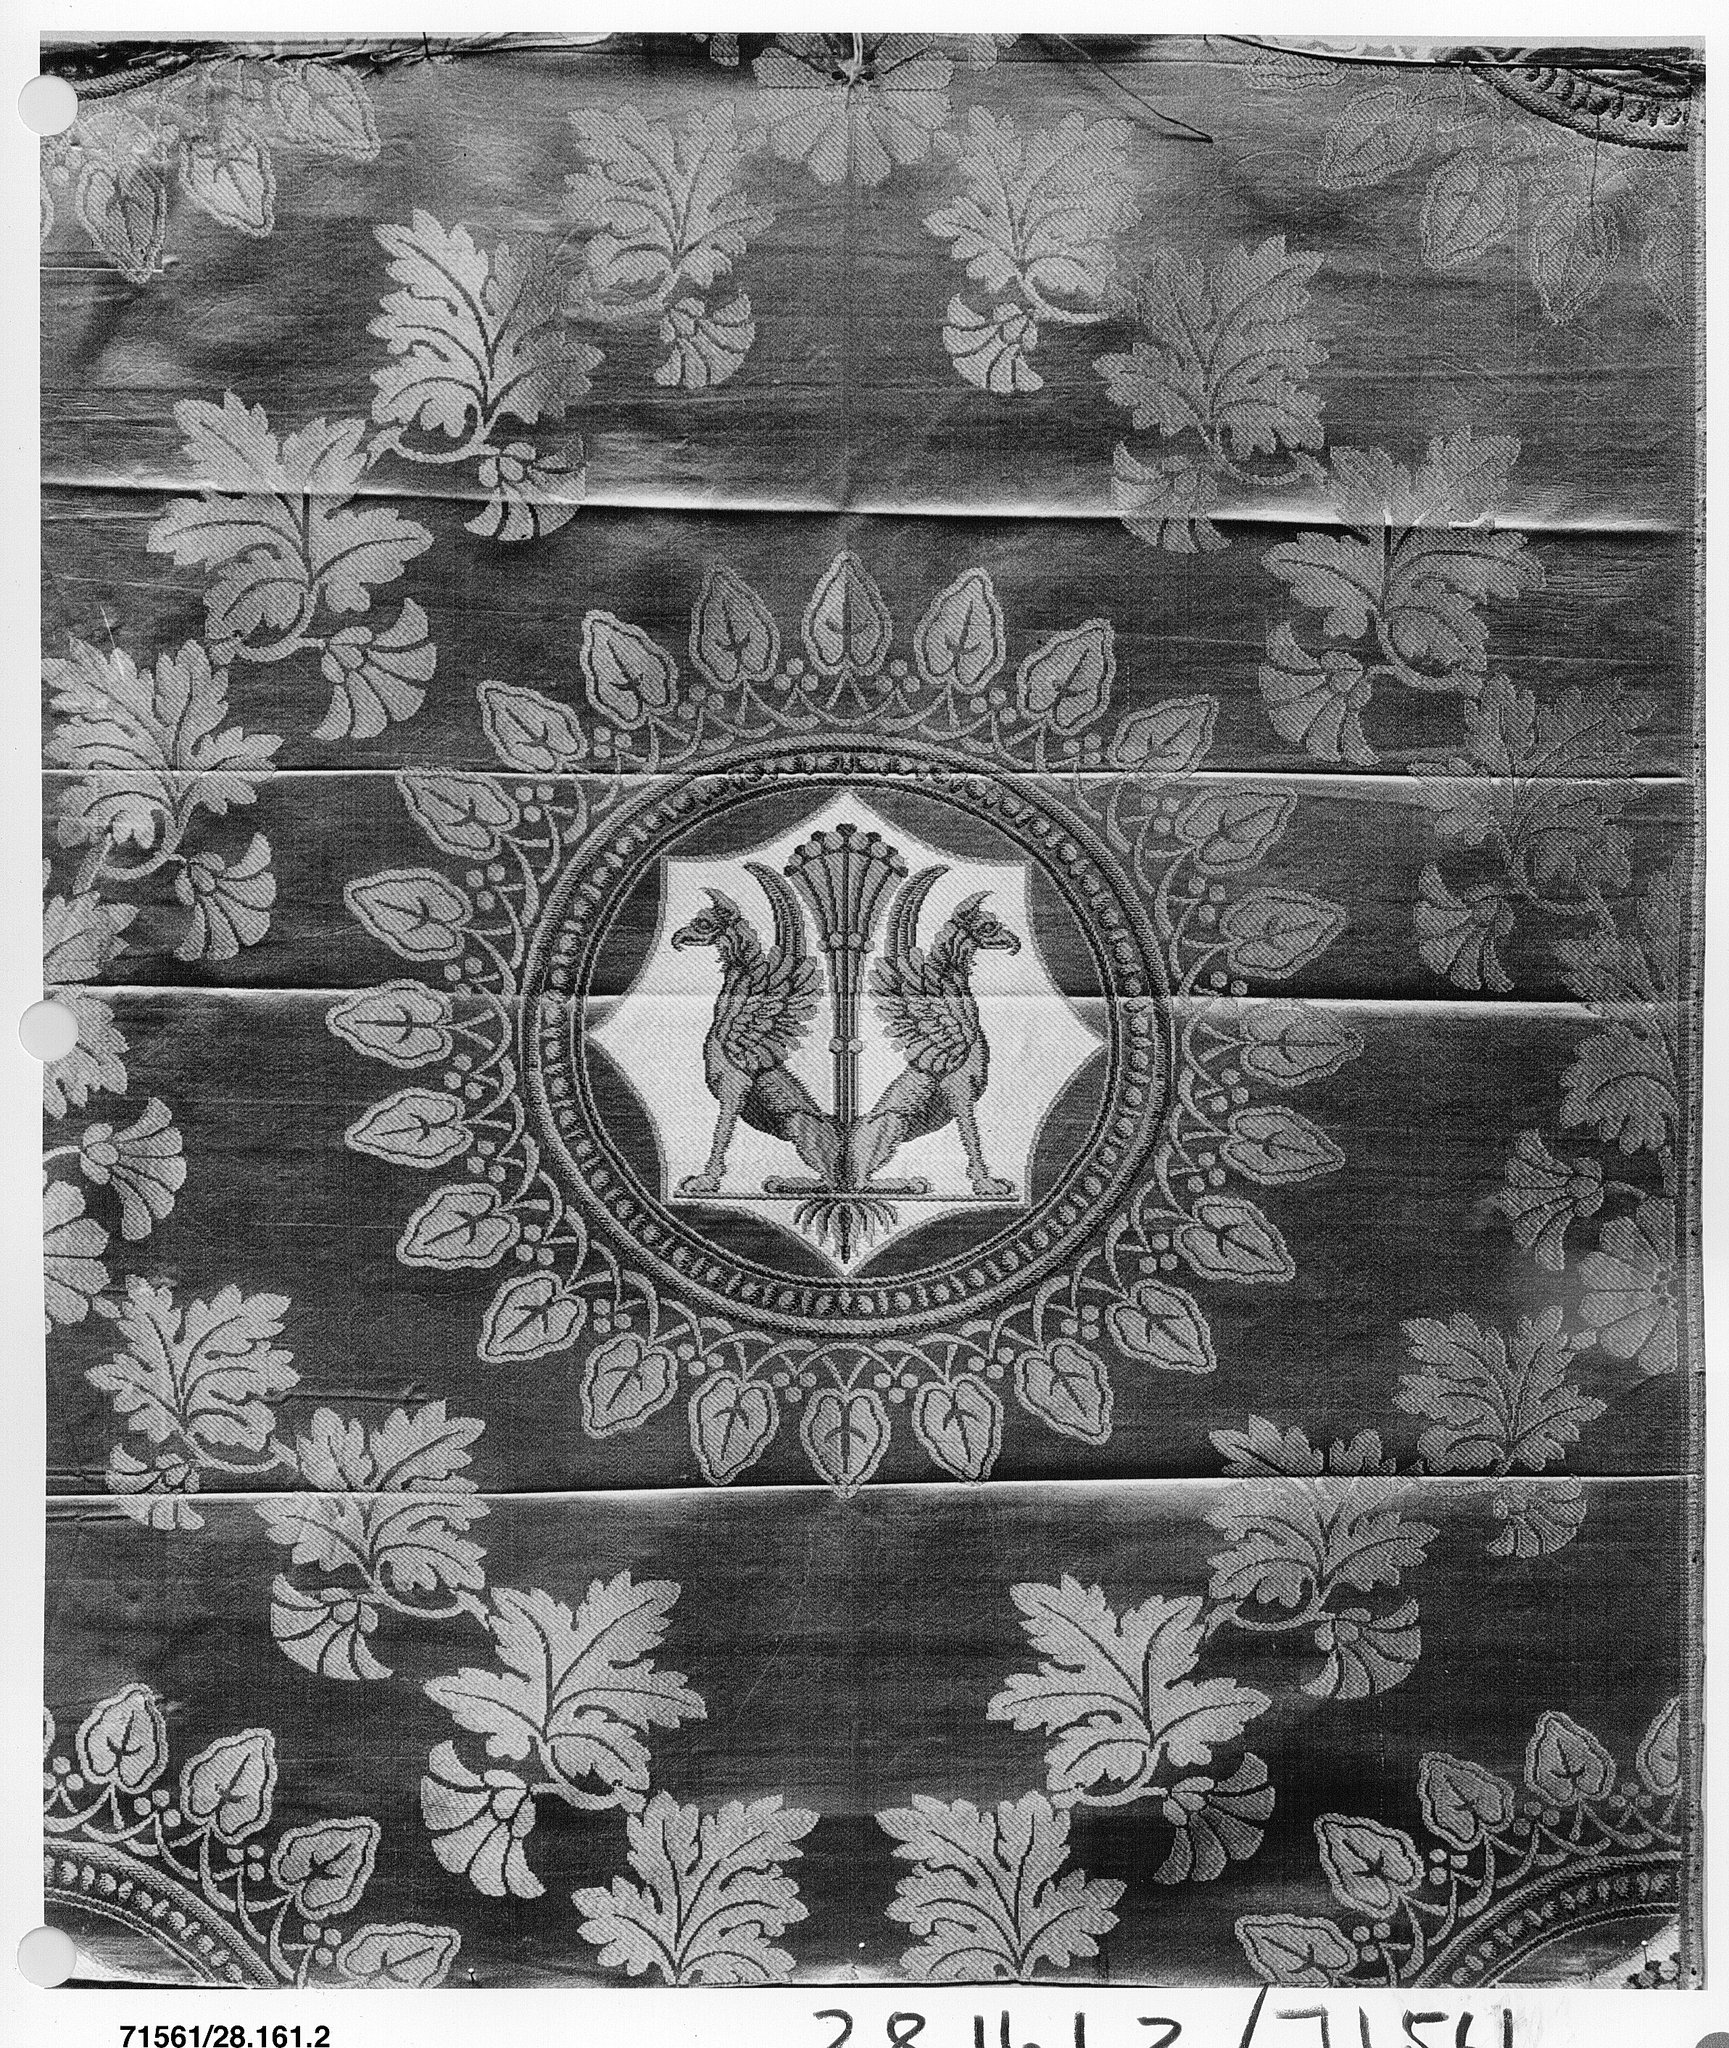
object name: upholstery panel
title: Chair seat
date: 1804-1814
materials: silk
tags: griffins